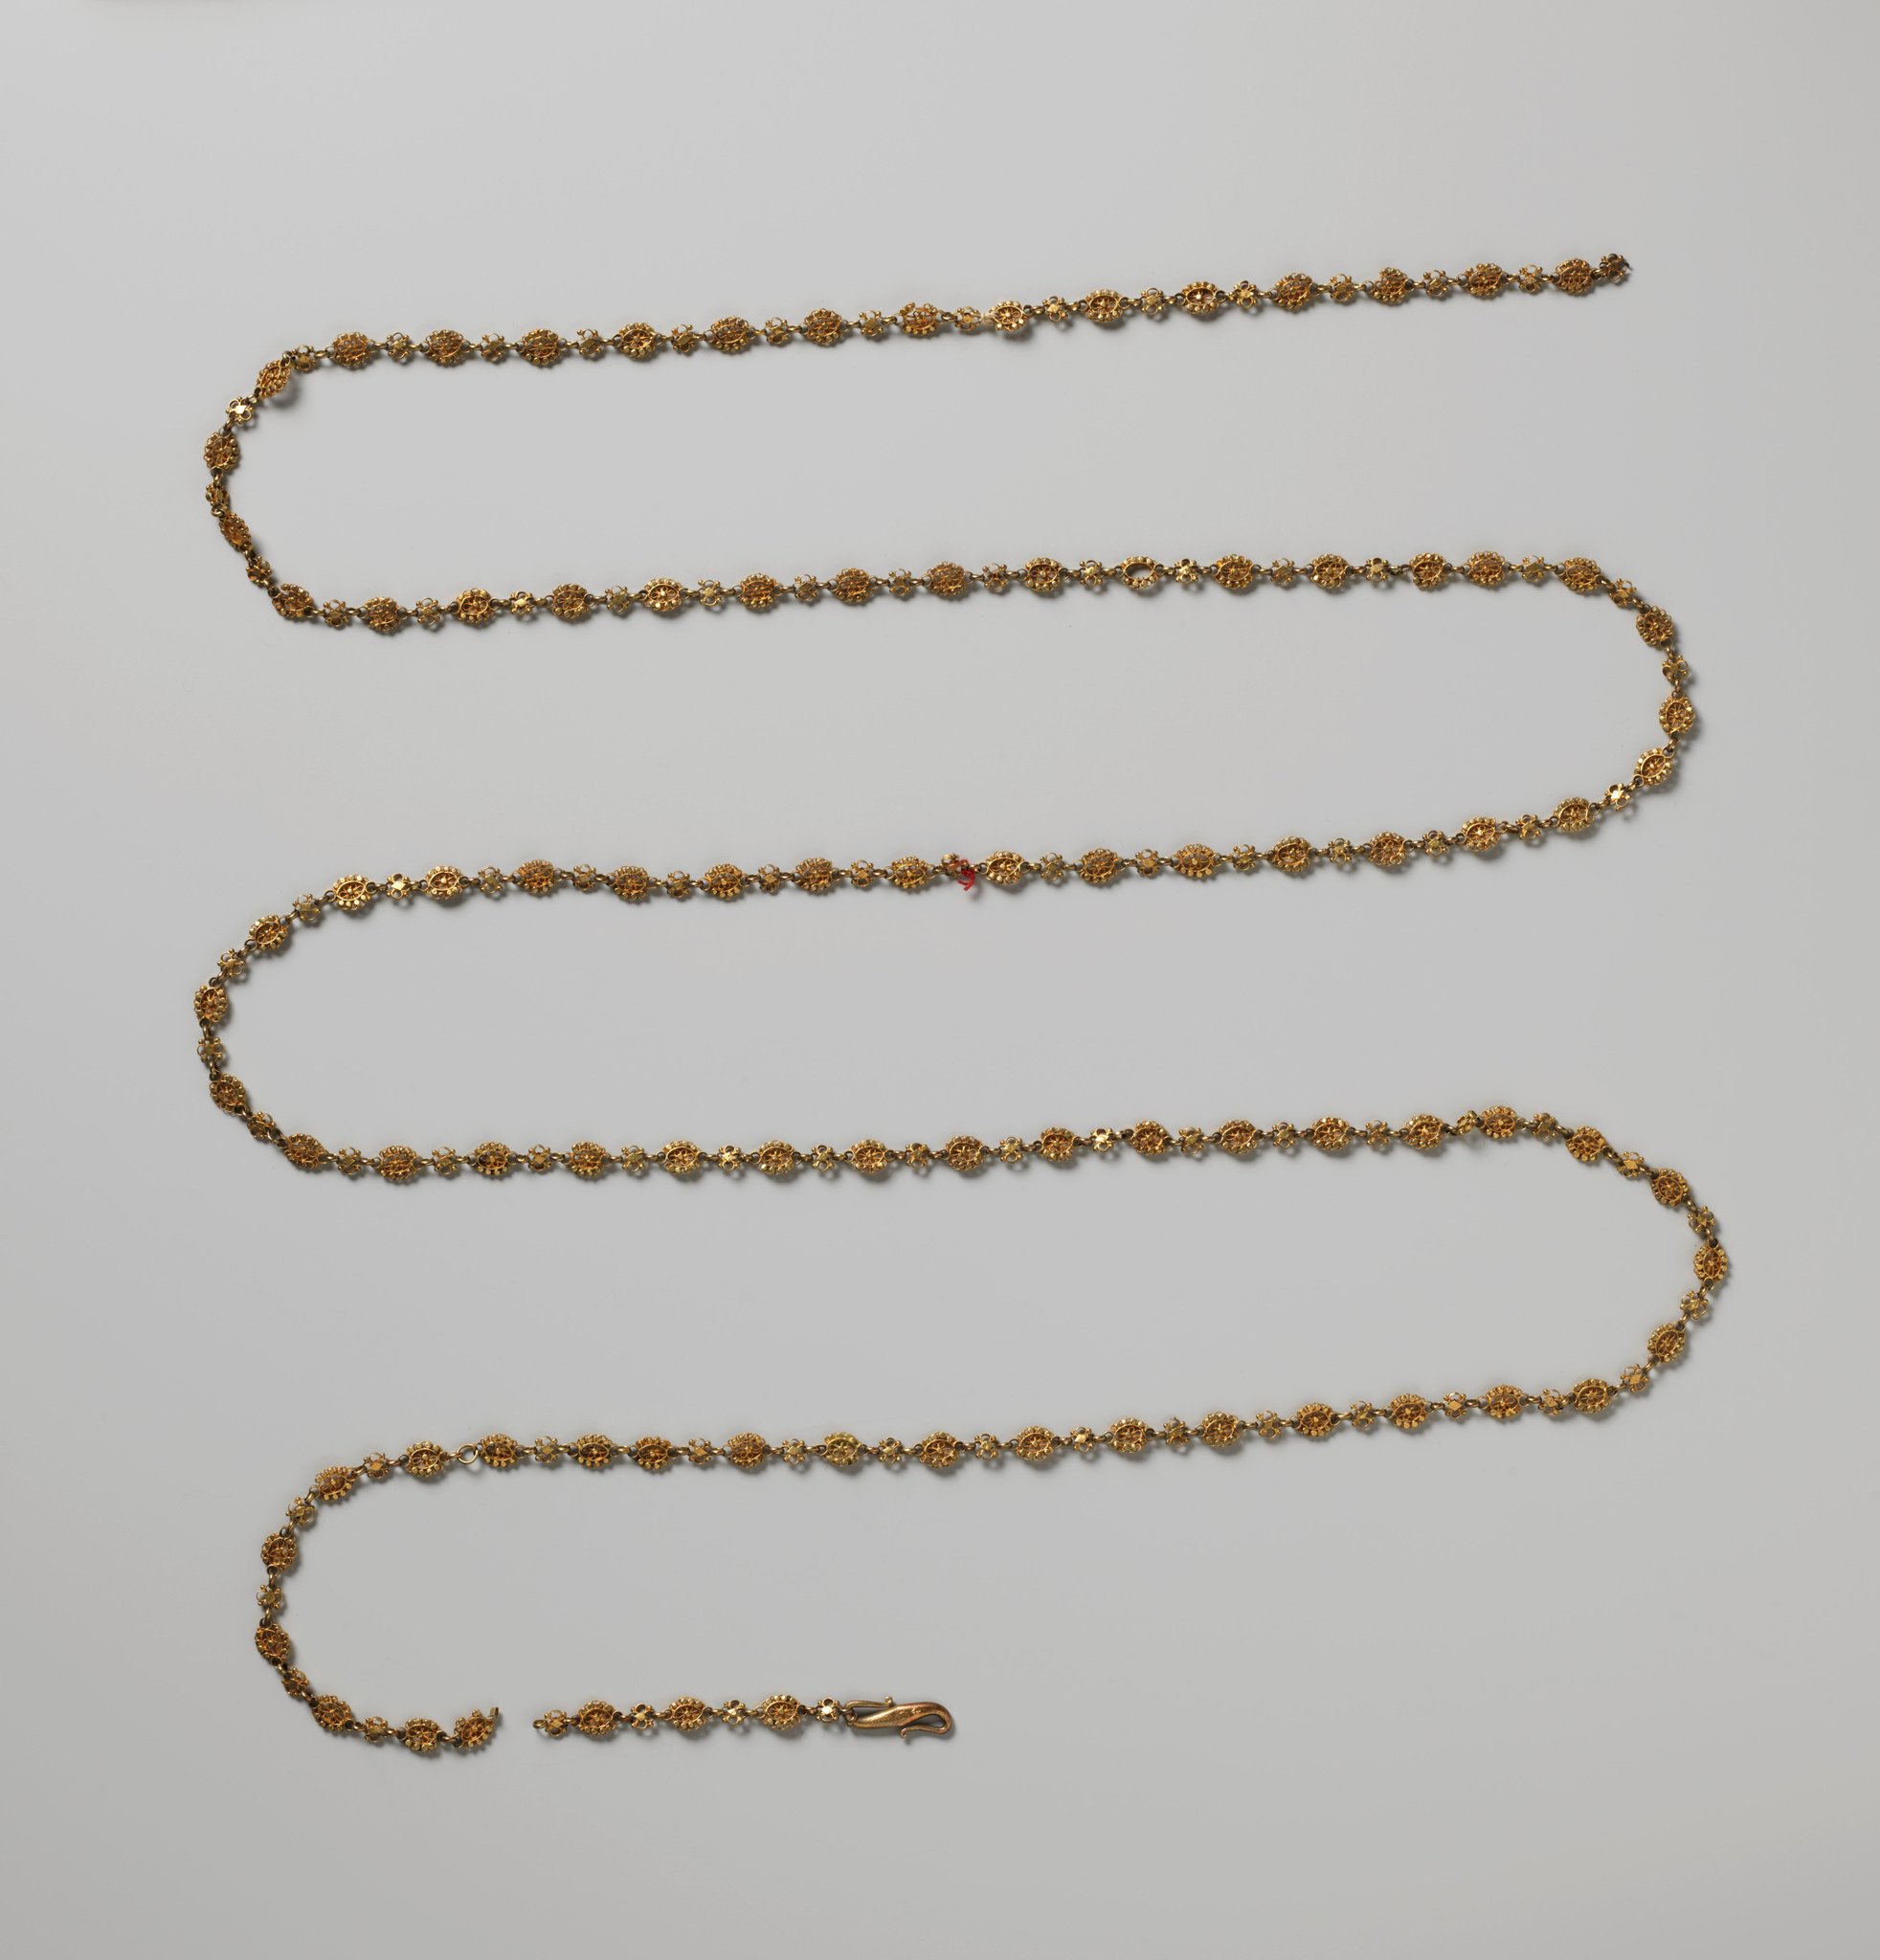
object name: chain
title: Ketting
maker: Anonymous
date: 1800-1900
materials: gold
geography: java